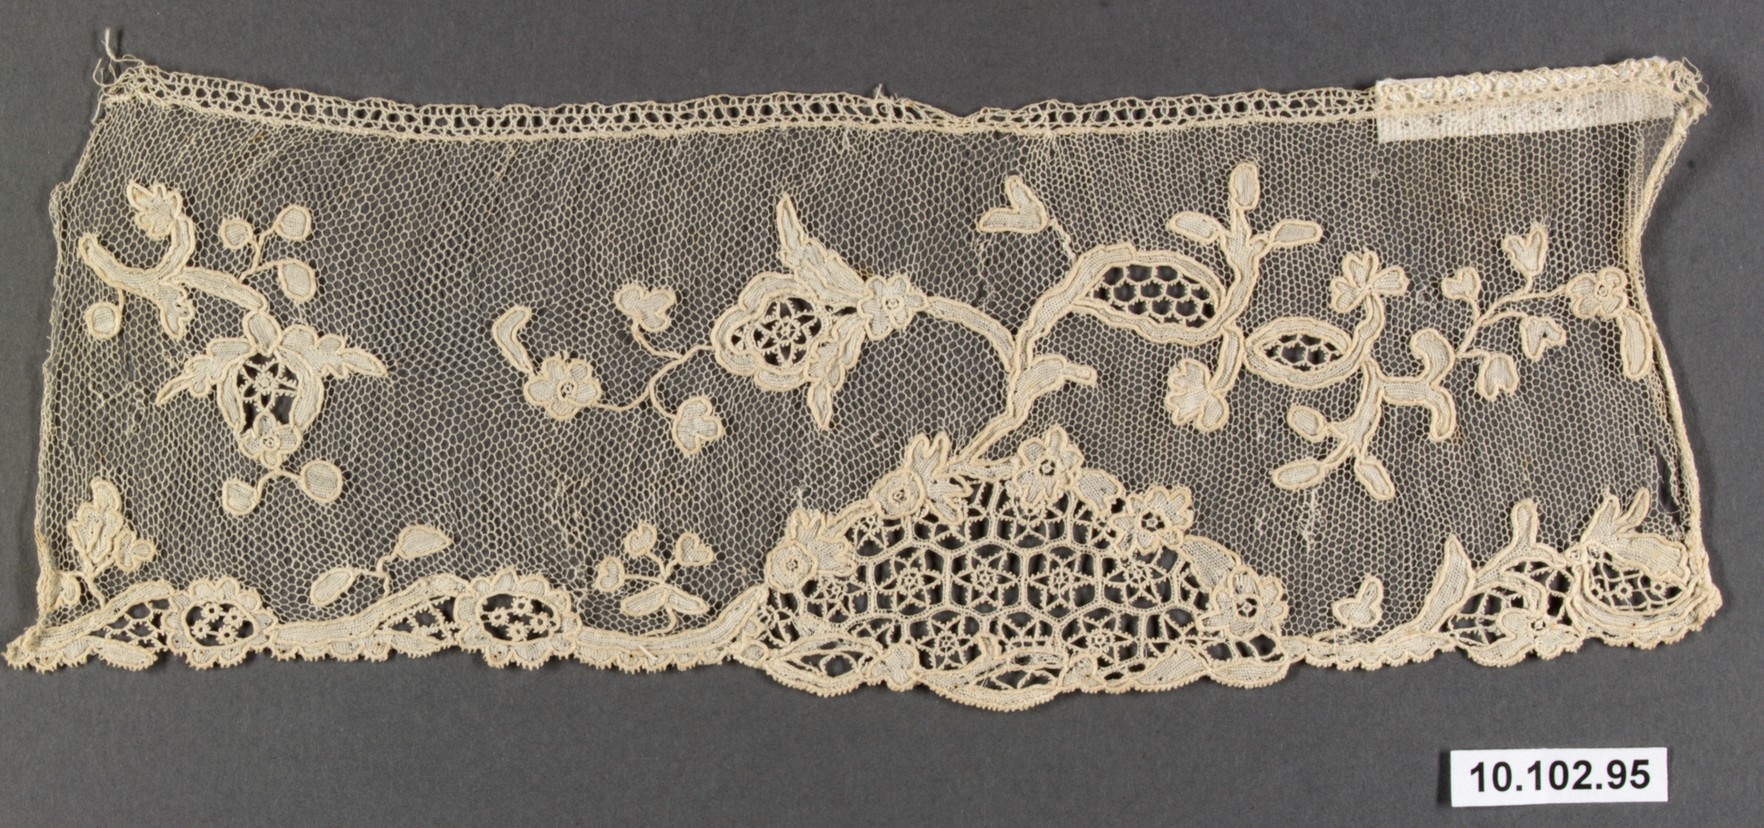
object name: piece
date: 1701-1800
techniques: lace